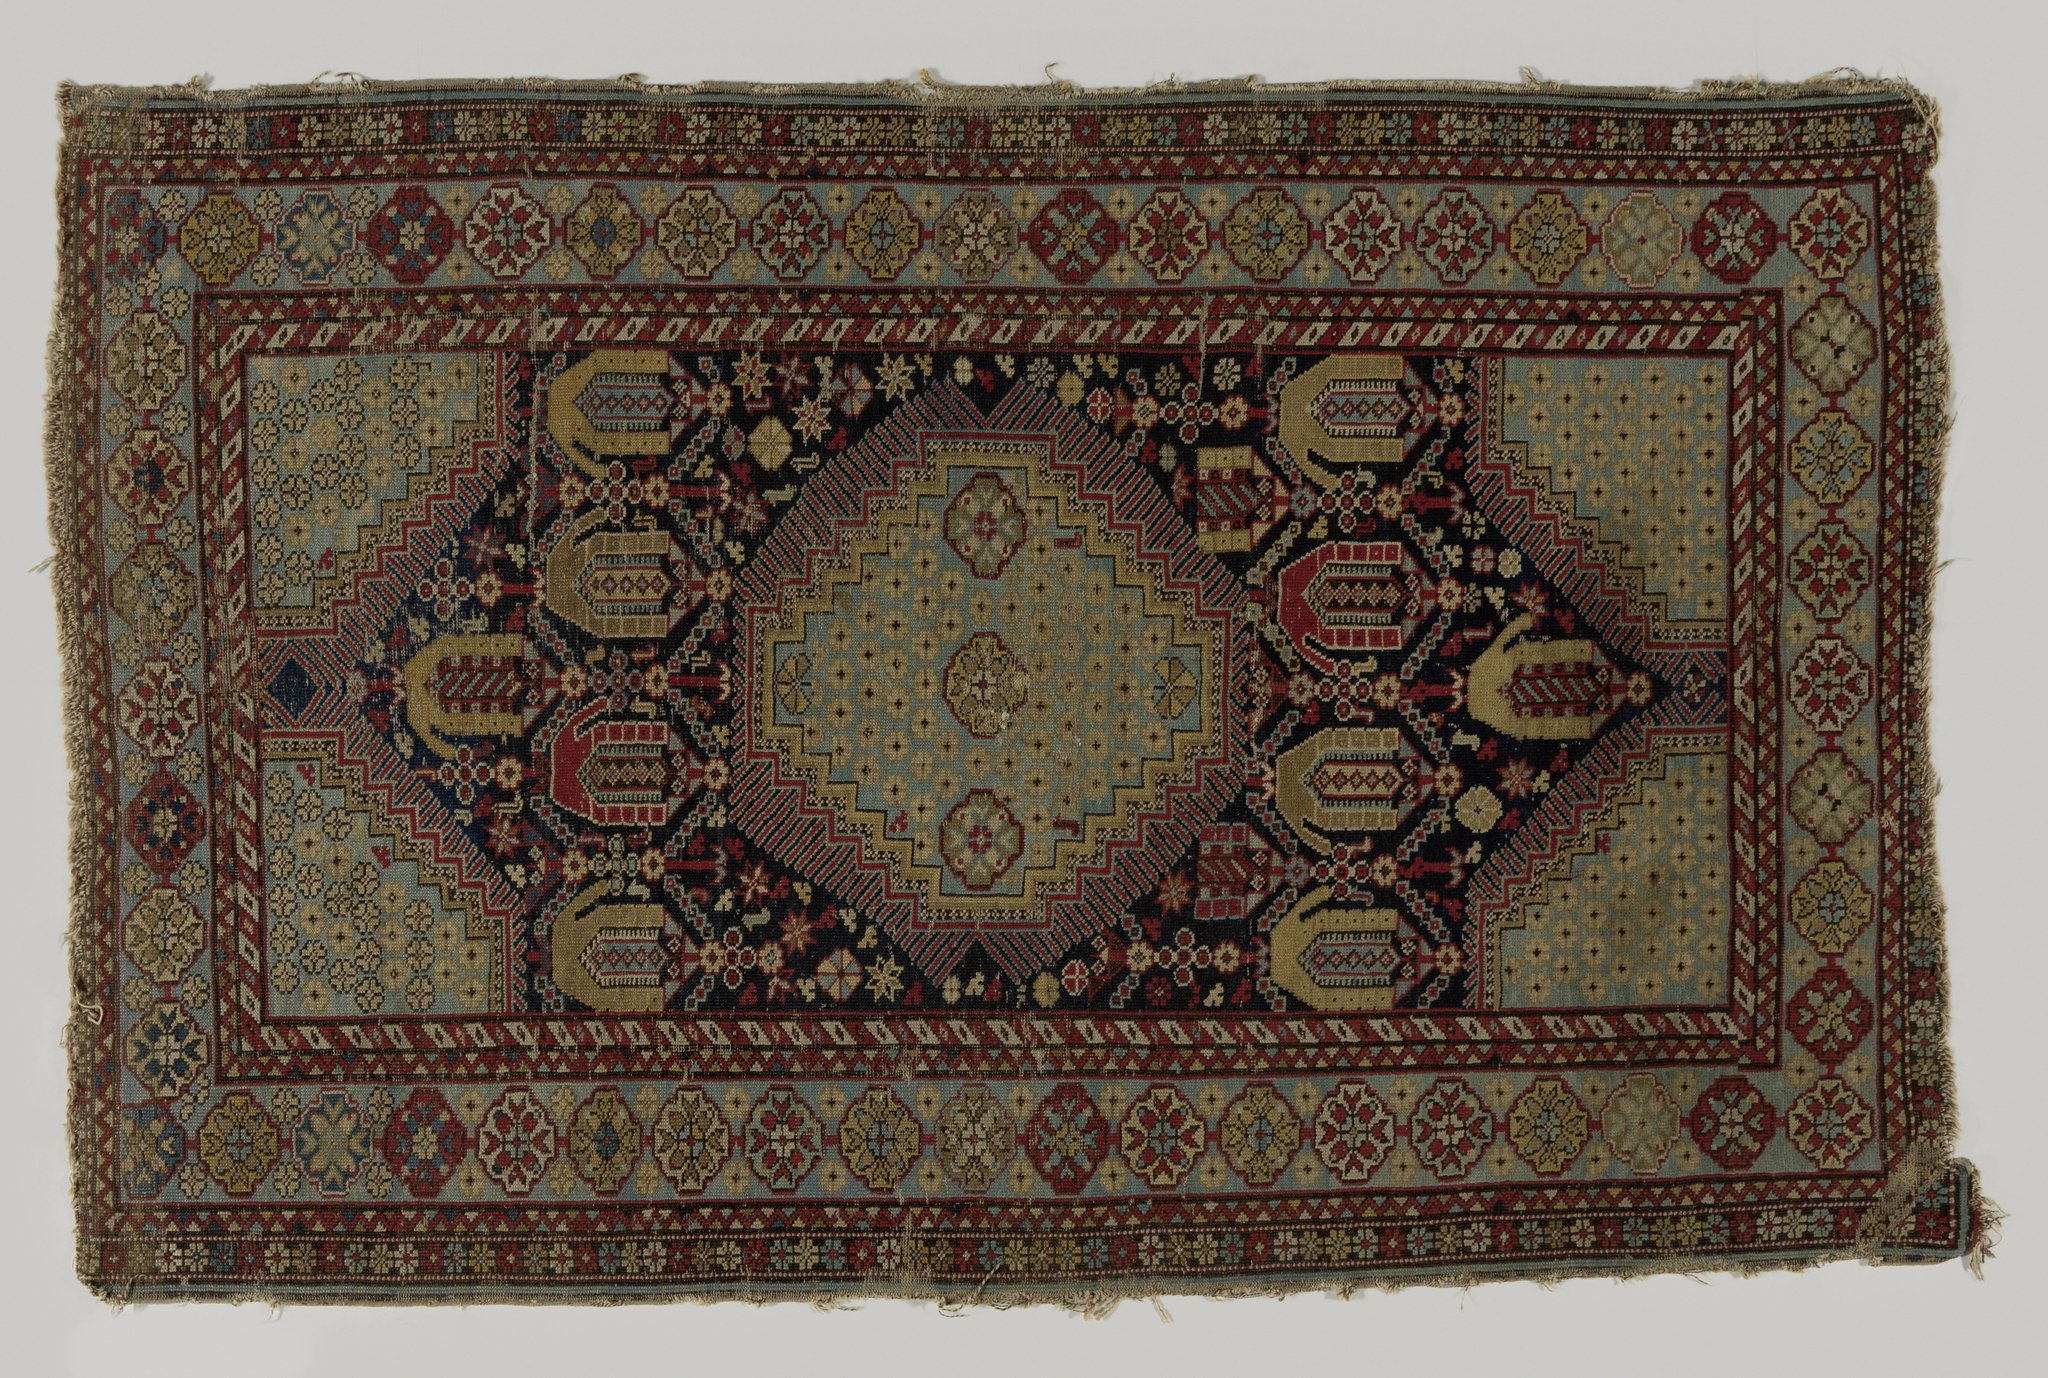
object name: oriental rug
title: Oosters tapijt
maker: Anonymous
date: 1820-1825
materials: wool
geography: khila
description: Oosters tapijt, bloemenkleed, van geknoopte wol, versierd met een dubbele mihrab op het middenveld; hierop een ruitvormig medaillon versierd met bloemen. Rondom rijen botehs. Vijf randen rondom, waarvan de middelste versierd is met rozetten.